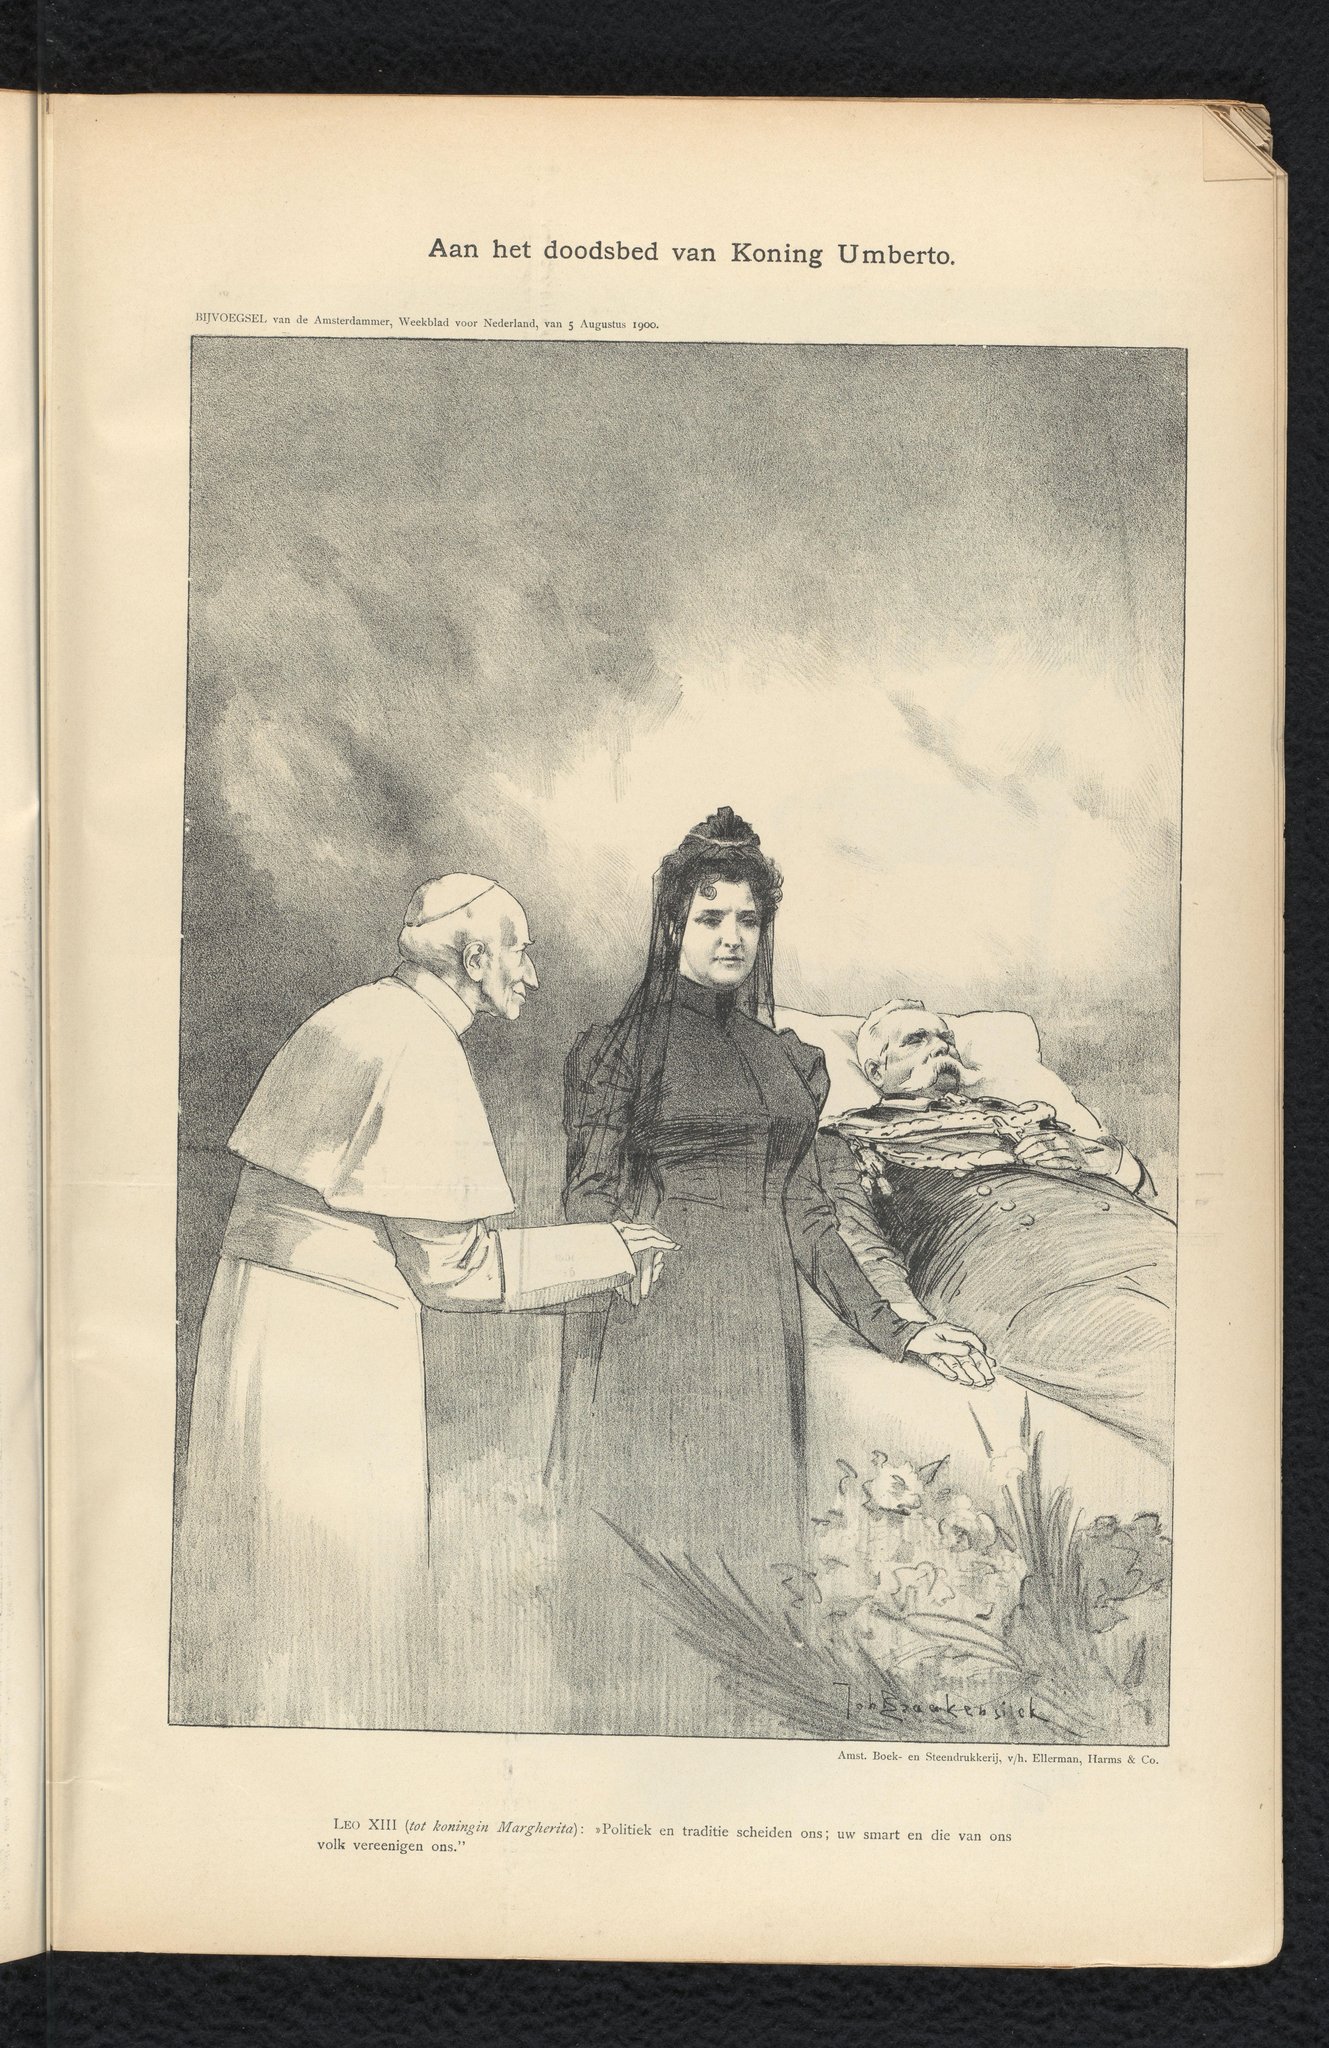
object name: cartoon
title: Aan het doodsbed van Koning Umberto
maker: johan braakensiek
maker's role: draughtsman, print maker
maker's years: 1858-1940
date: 1900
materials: paper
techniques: lithograph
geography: amsterdam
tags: rome, leo xiii, deathbed, widow, pope, lying in state, political caricatures and satires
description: Paus Leo XIII probeert koningin Margaretha van Savoye, de weduwe van de Italiaanse koning Umberto I, te troosten bij het overlijden van haar echtgenoot. Rechts het doodsbed van de koning.